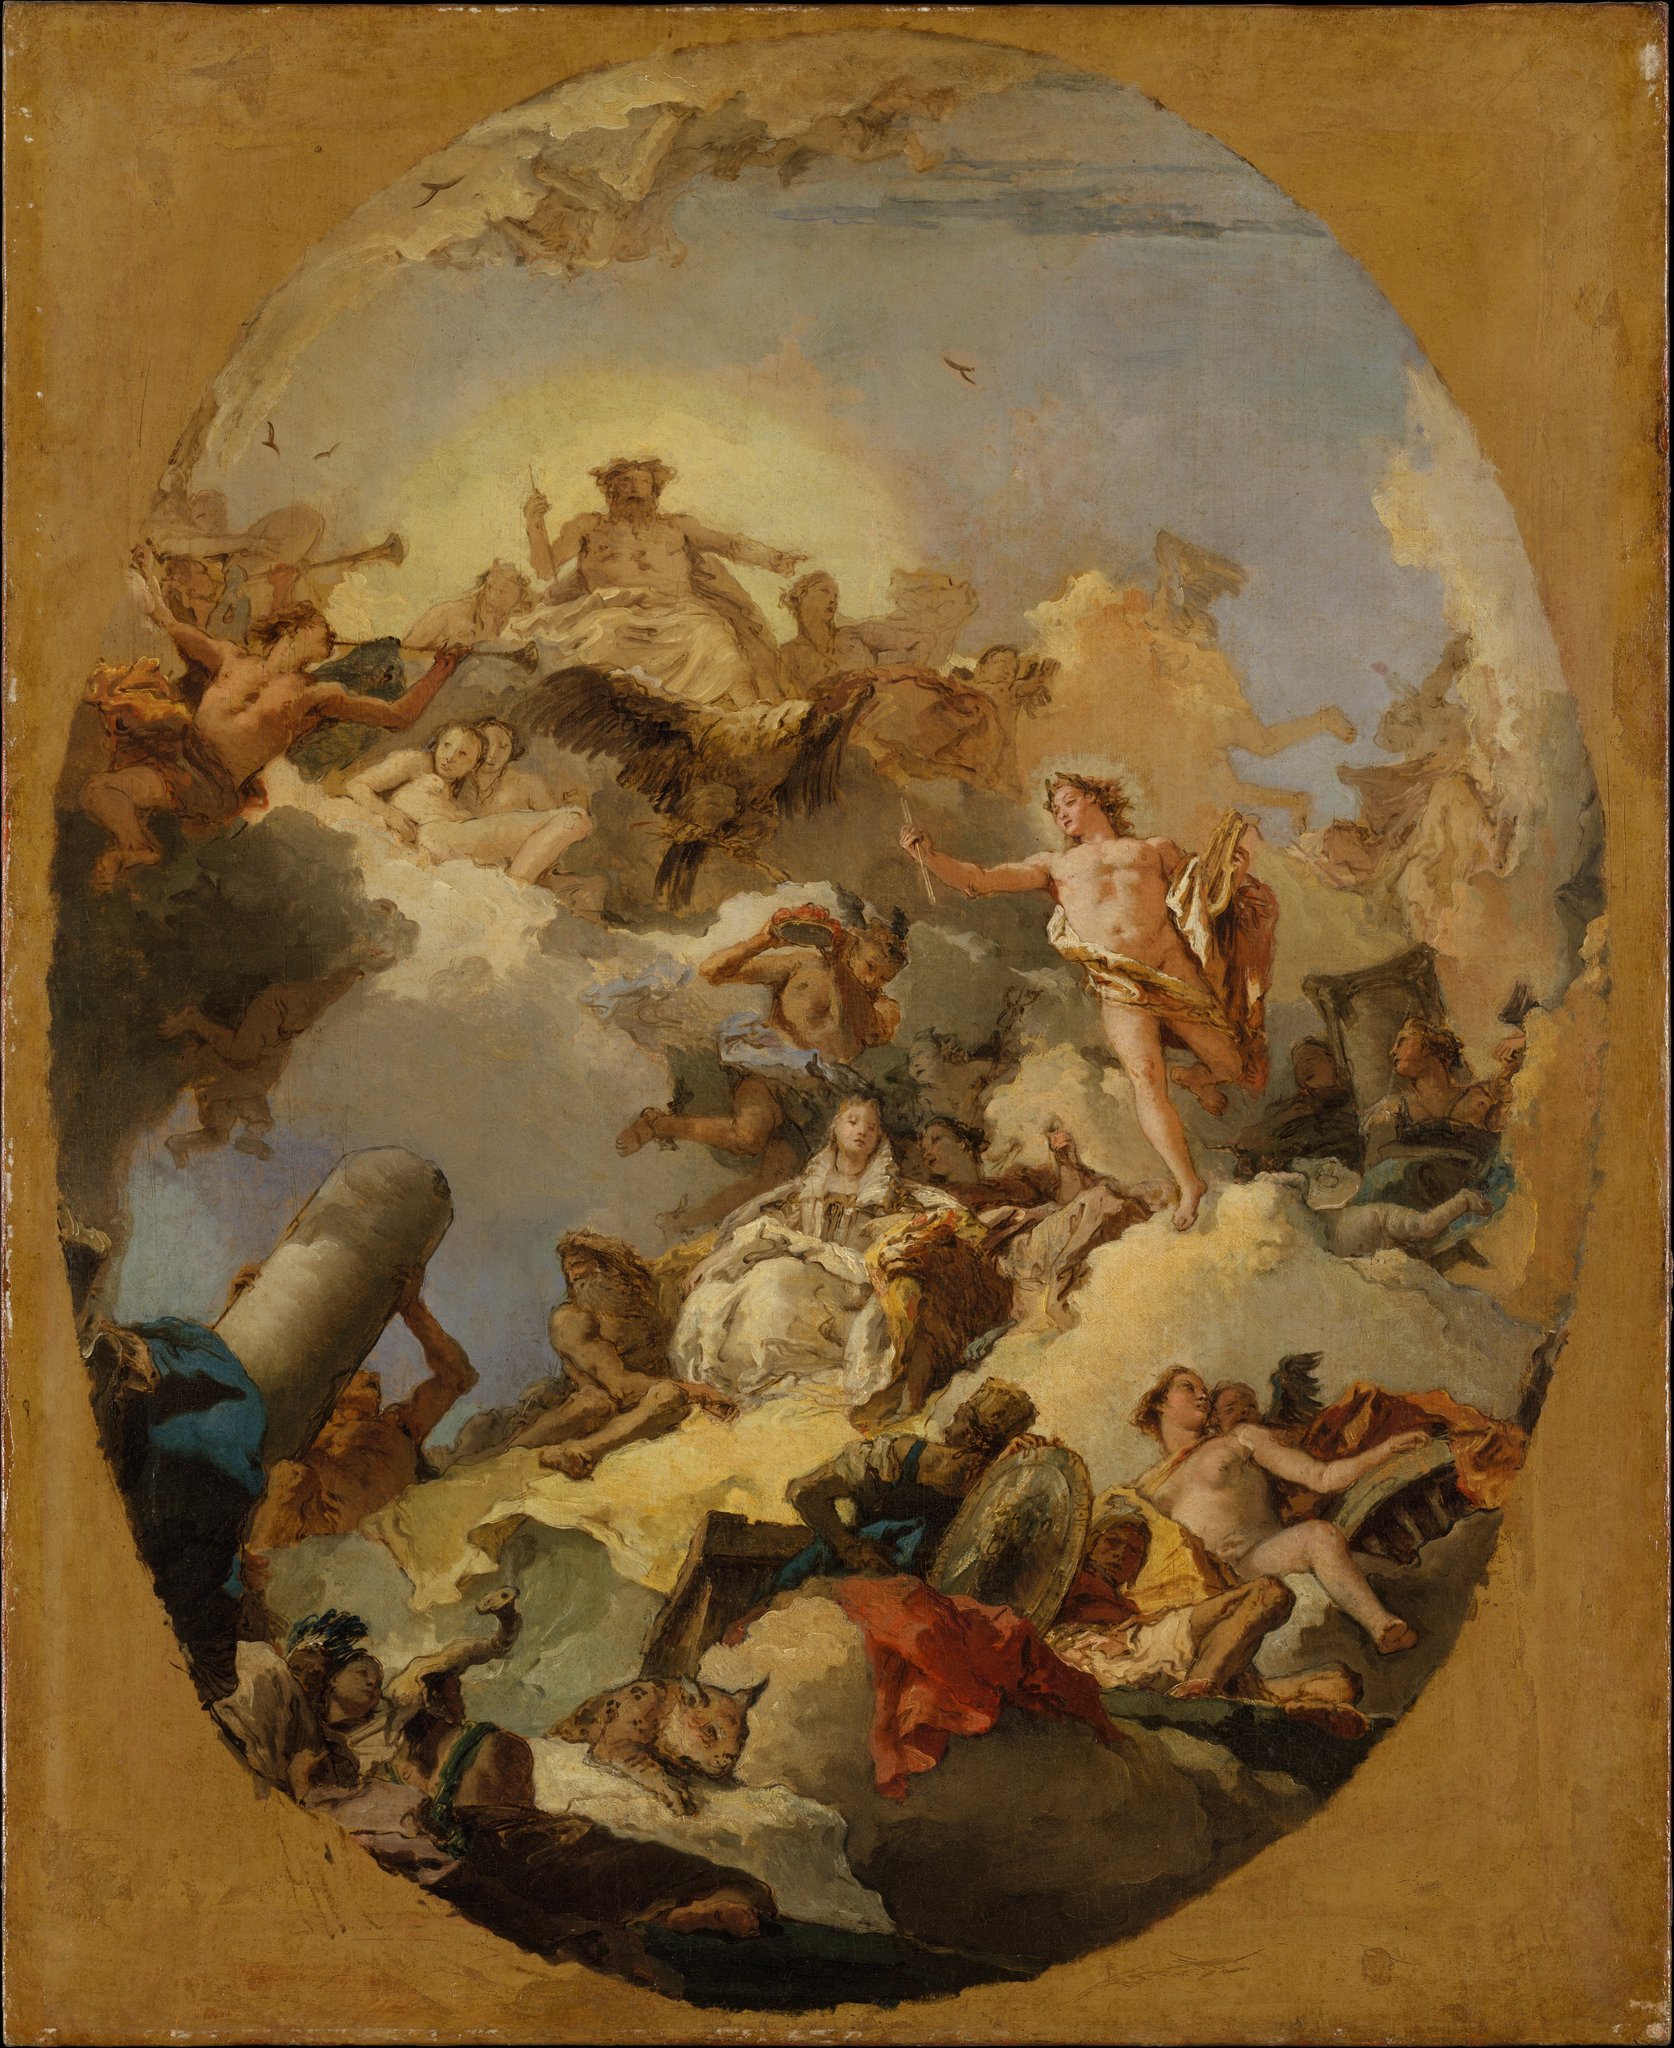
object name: painting, sketch for a ceiling painting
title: The Apotheosis of the Spanish Monarchy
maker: giovanni battista tiepolo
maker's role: artist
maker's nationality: italian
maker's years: 1696-1770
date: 1760-1769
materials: canvas, oil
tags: eagles,apollo,jupiter